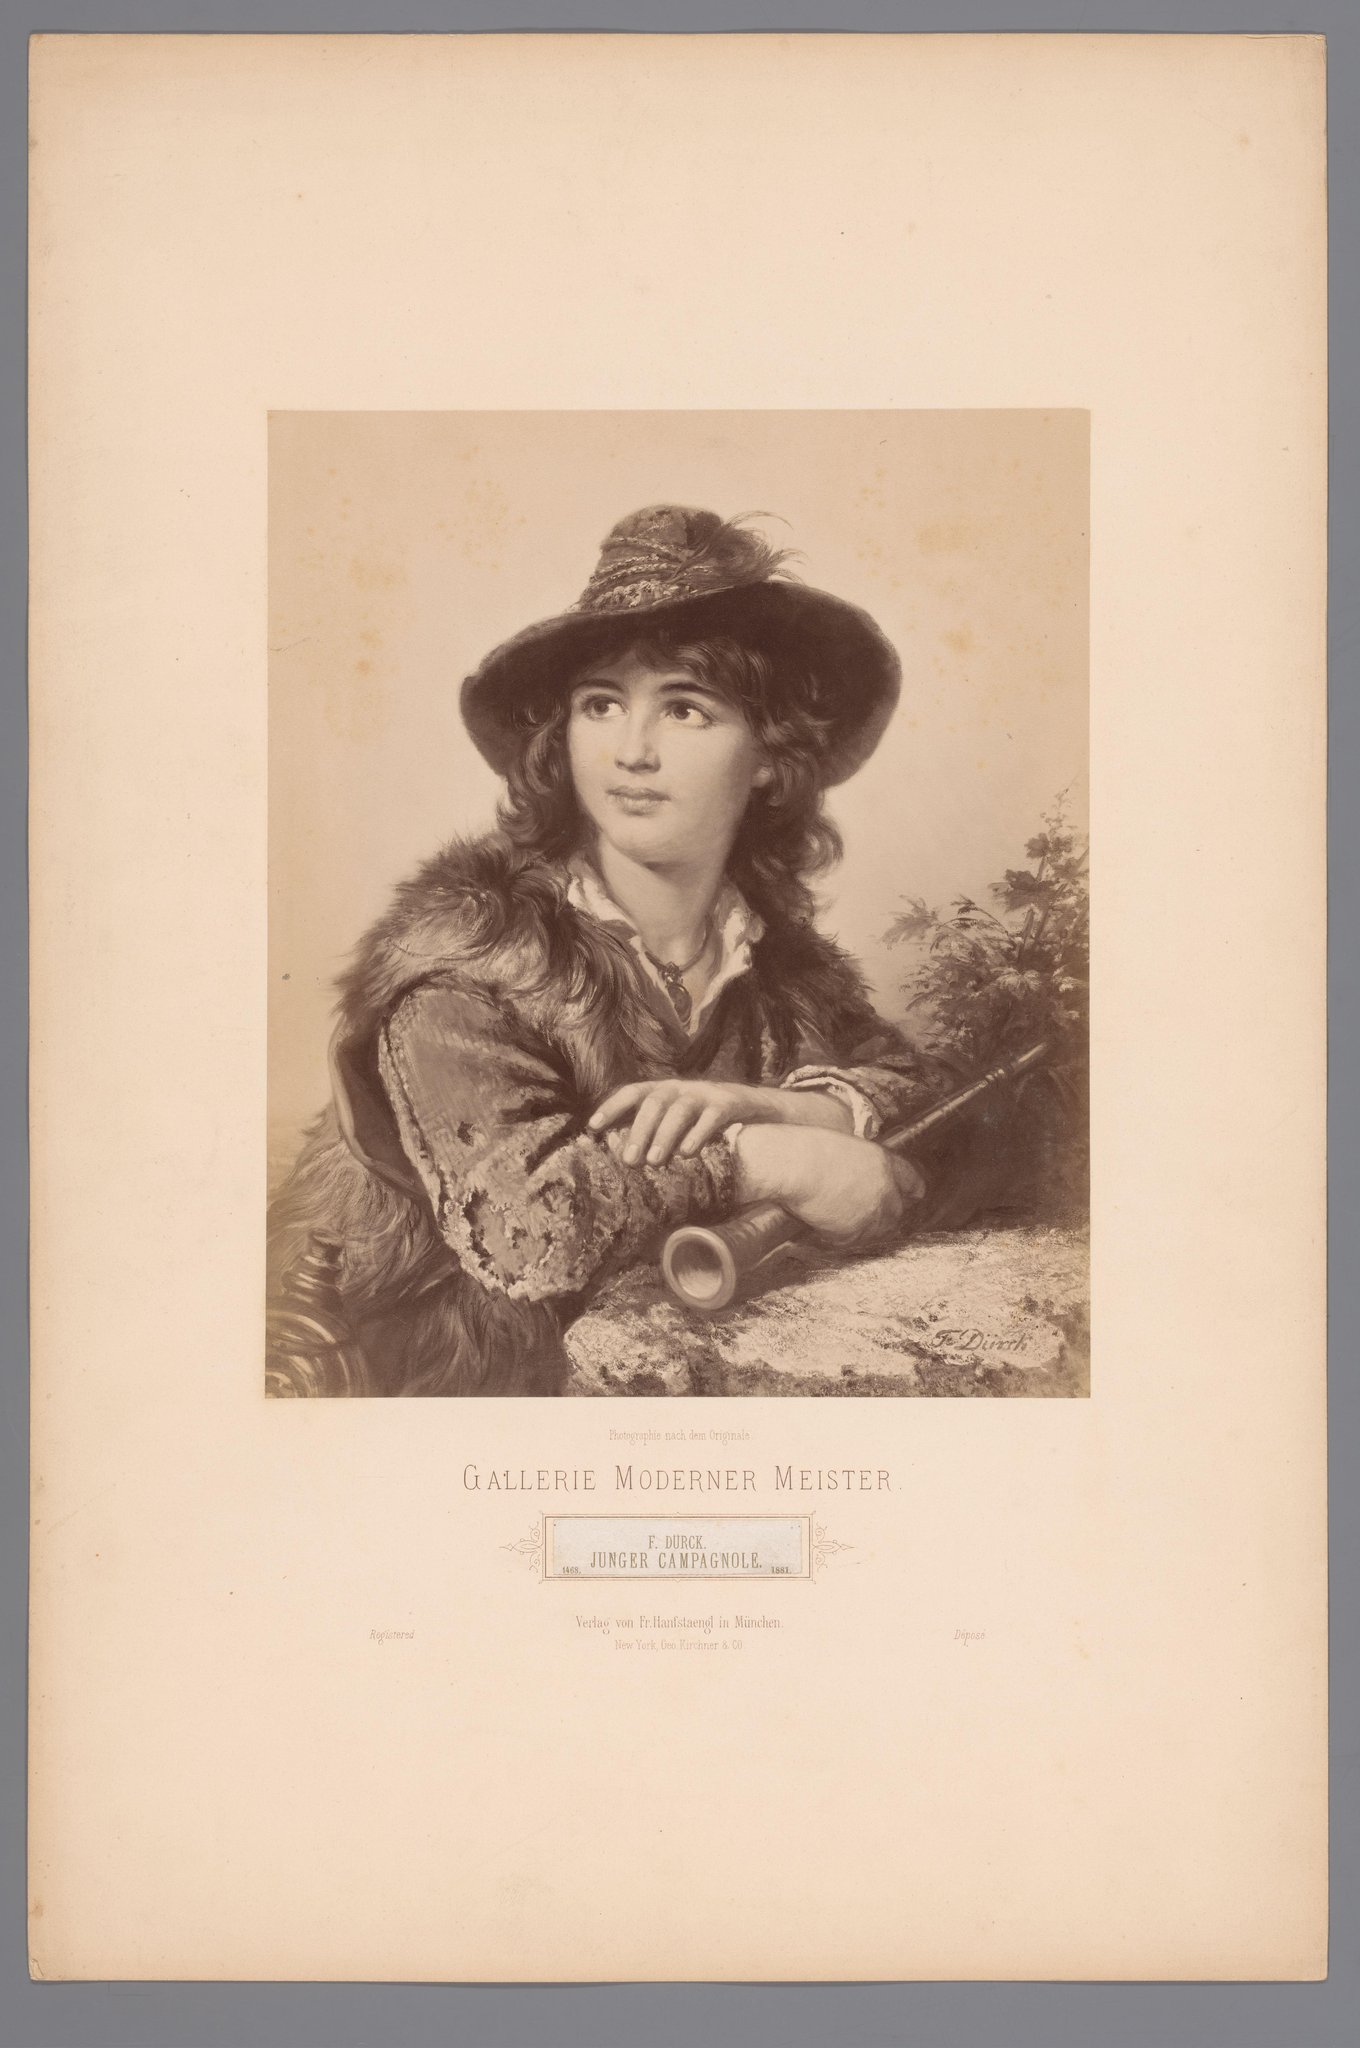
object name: photograph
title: Gallerie Moderner Meister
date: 1881-1900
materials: cardboard, paper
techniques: albumen print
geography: munich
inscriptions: caption: ‘Photographie nach dem Originale.//GALLERIE MODERNER MEISTER//F. DÜRCK//JUNGER CAMPAGNOLE//1468//1881//Verlag von Fr. Hanfstaengl in München//New York, Geo. Kirchner & Co.//Registered//Déposé’